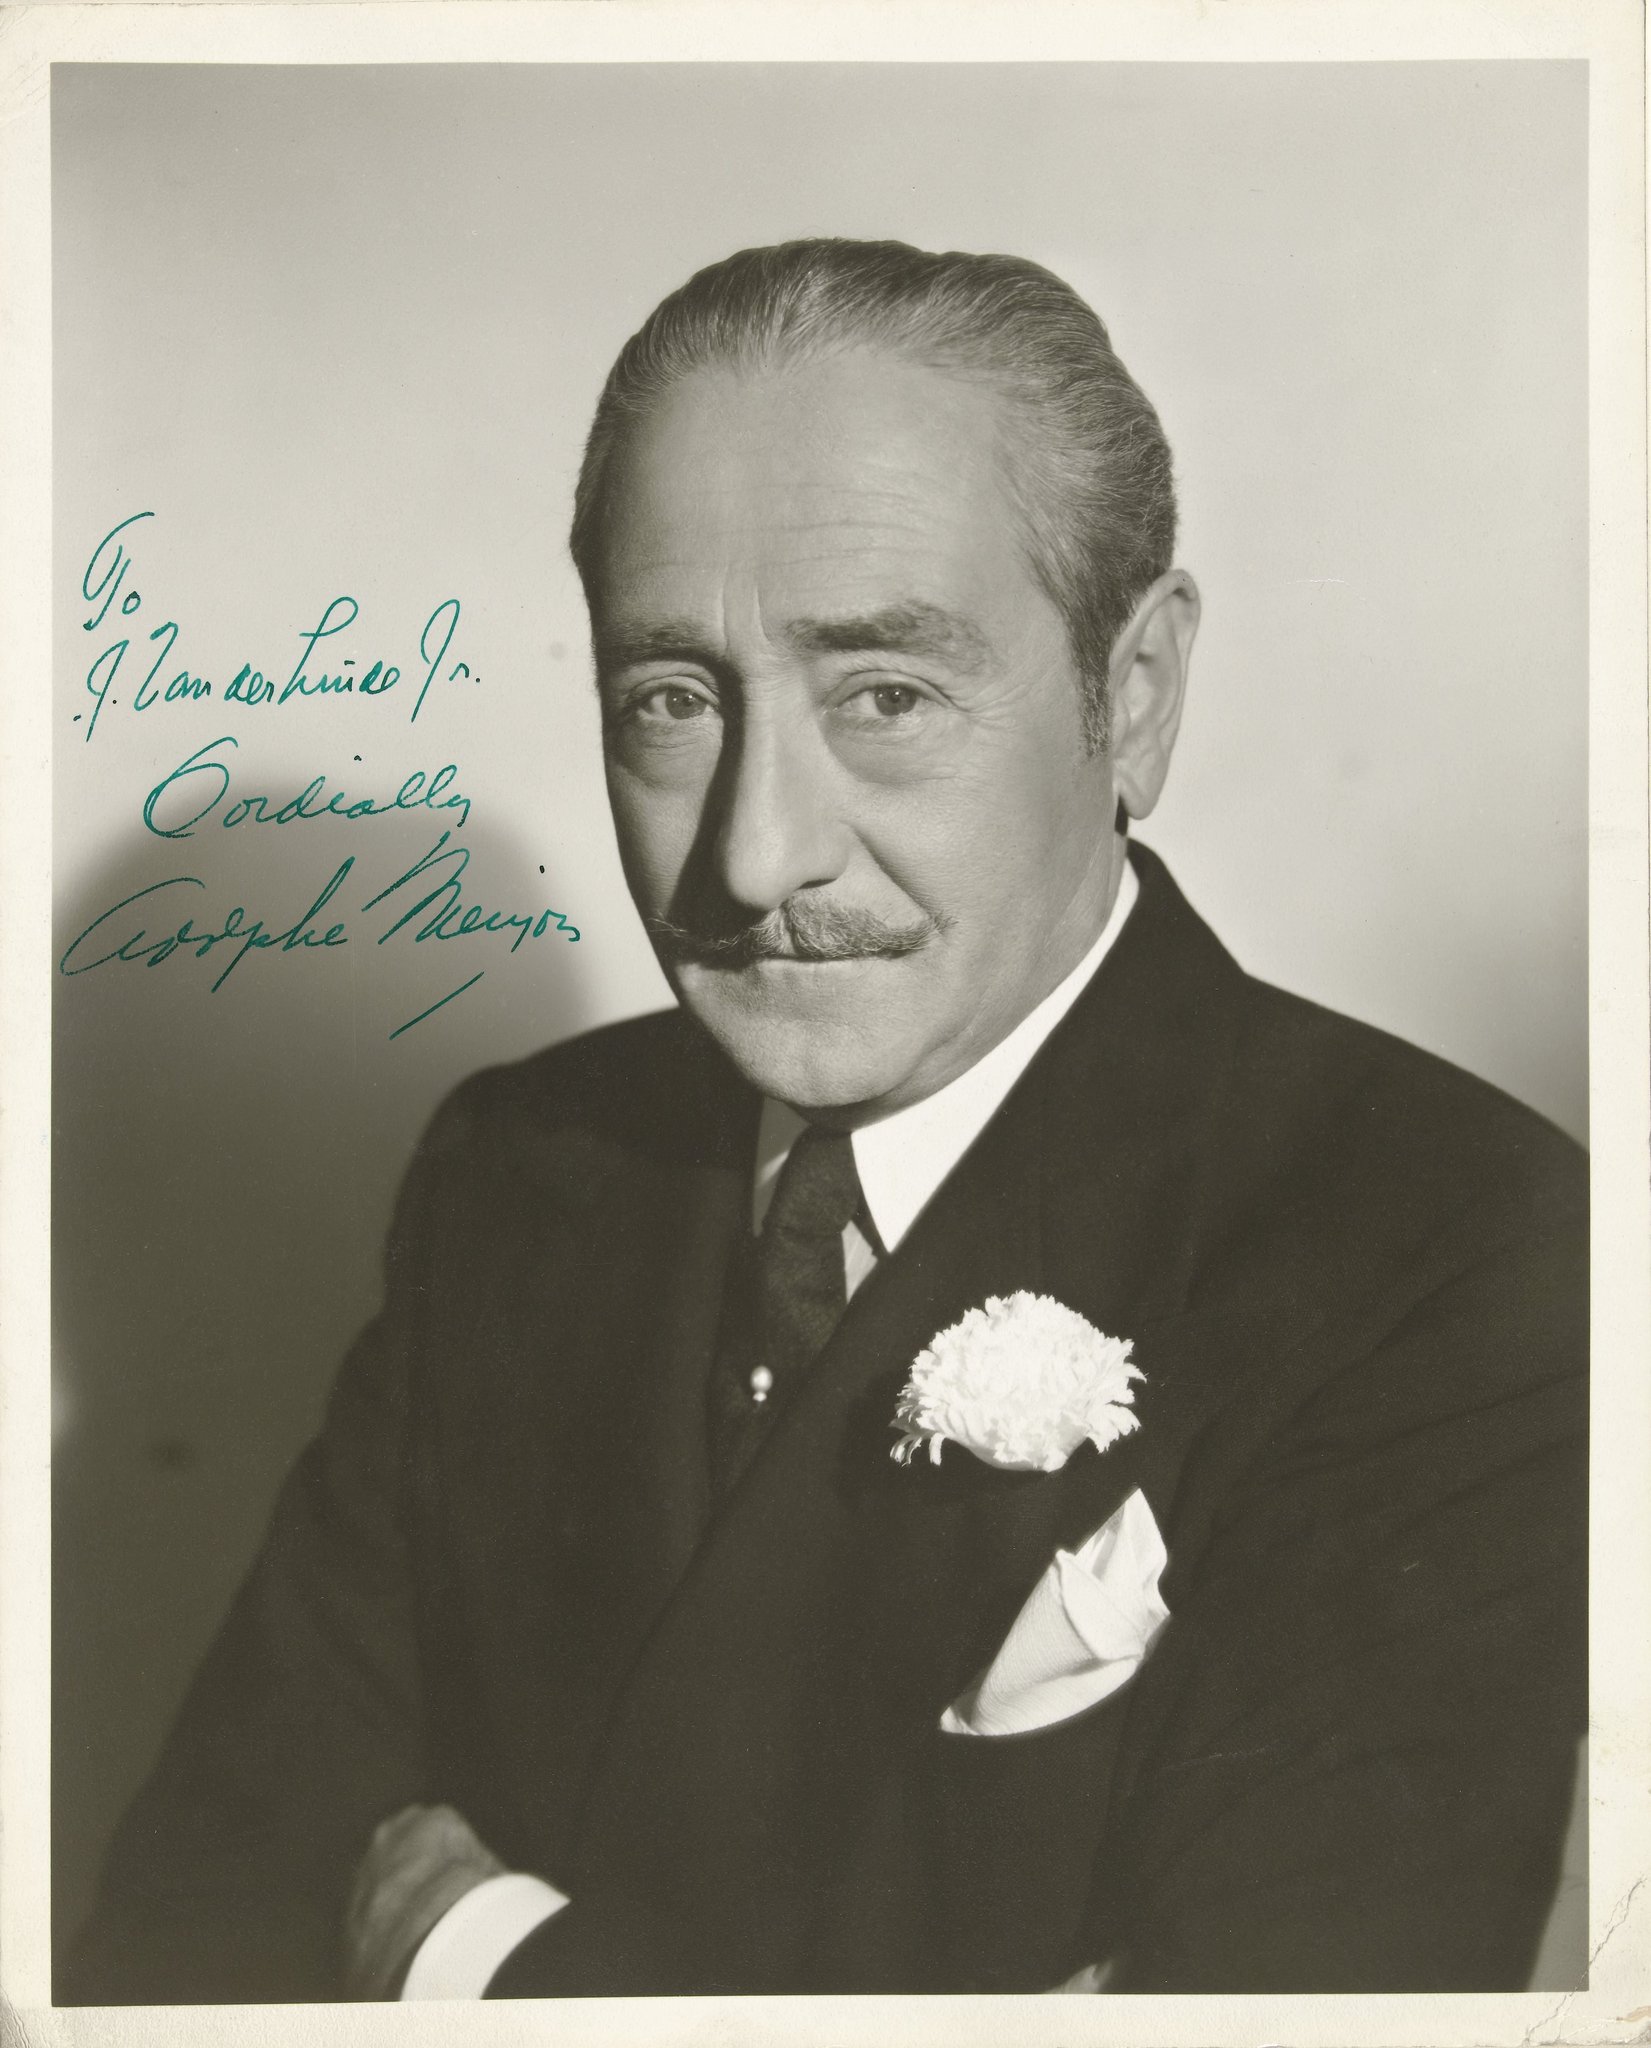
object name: photograph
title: Portret van Adolphe Menjou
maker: Anonymous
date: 1922-1942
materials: photographic support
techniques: gelatin silver print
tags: pittsburgh, acteur, adolphe menjou